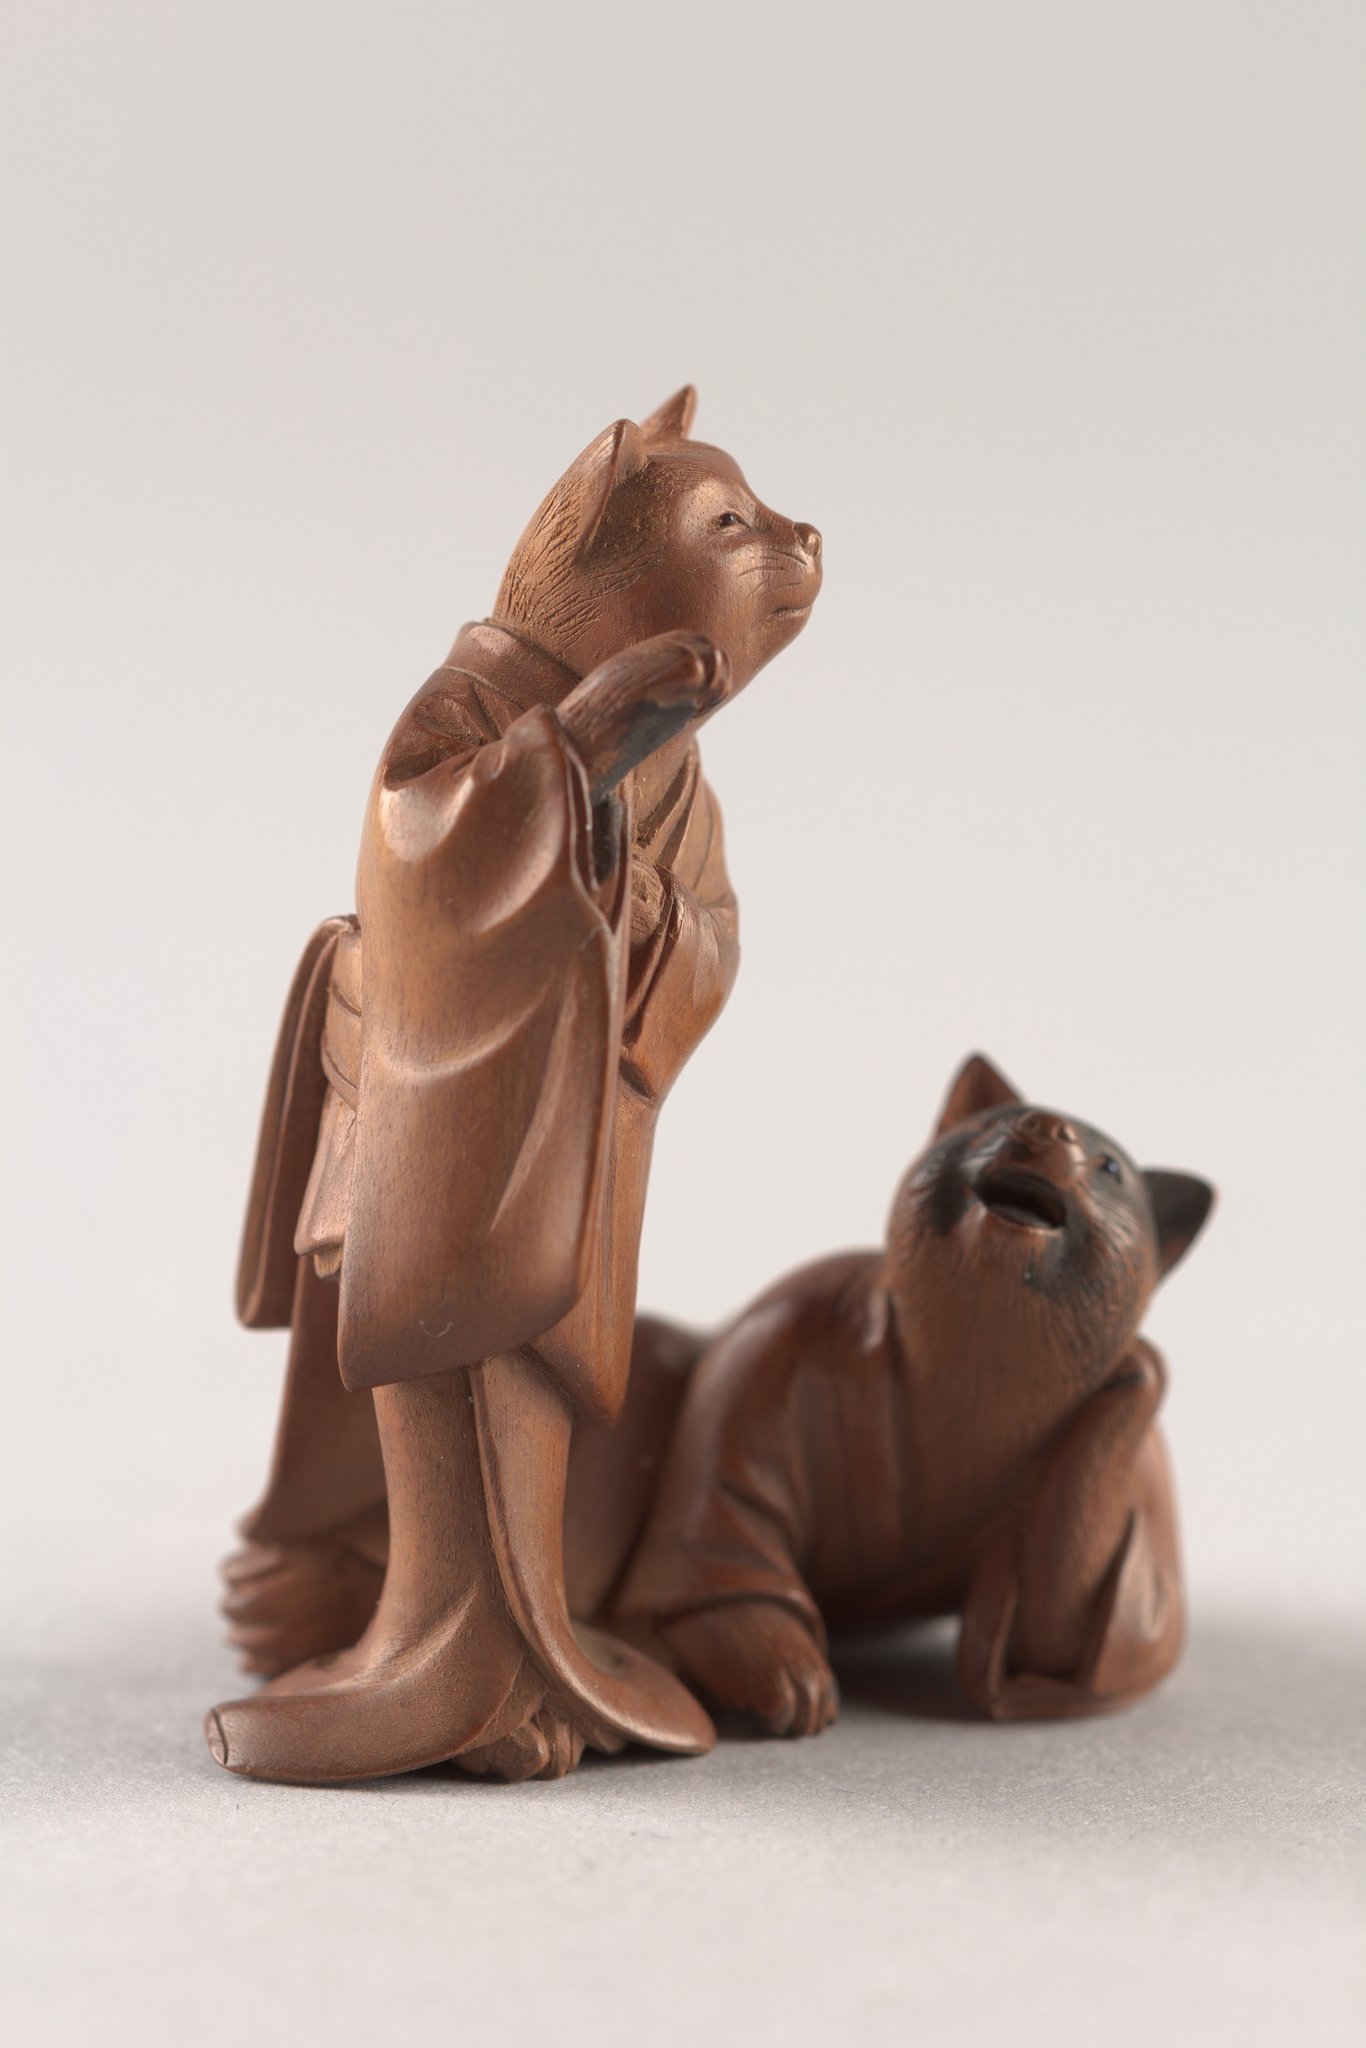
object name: netsuke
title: Netsuke of Two Cats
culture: japanese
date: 1801-1900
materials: wood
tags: cats